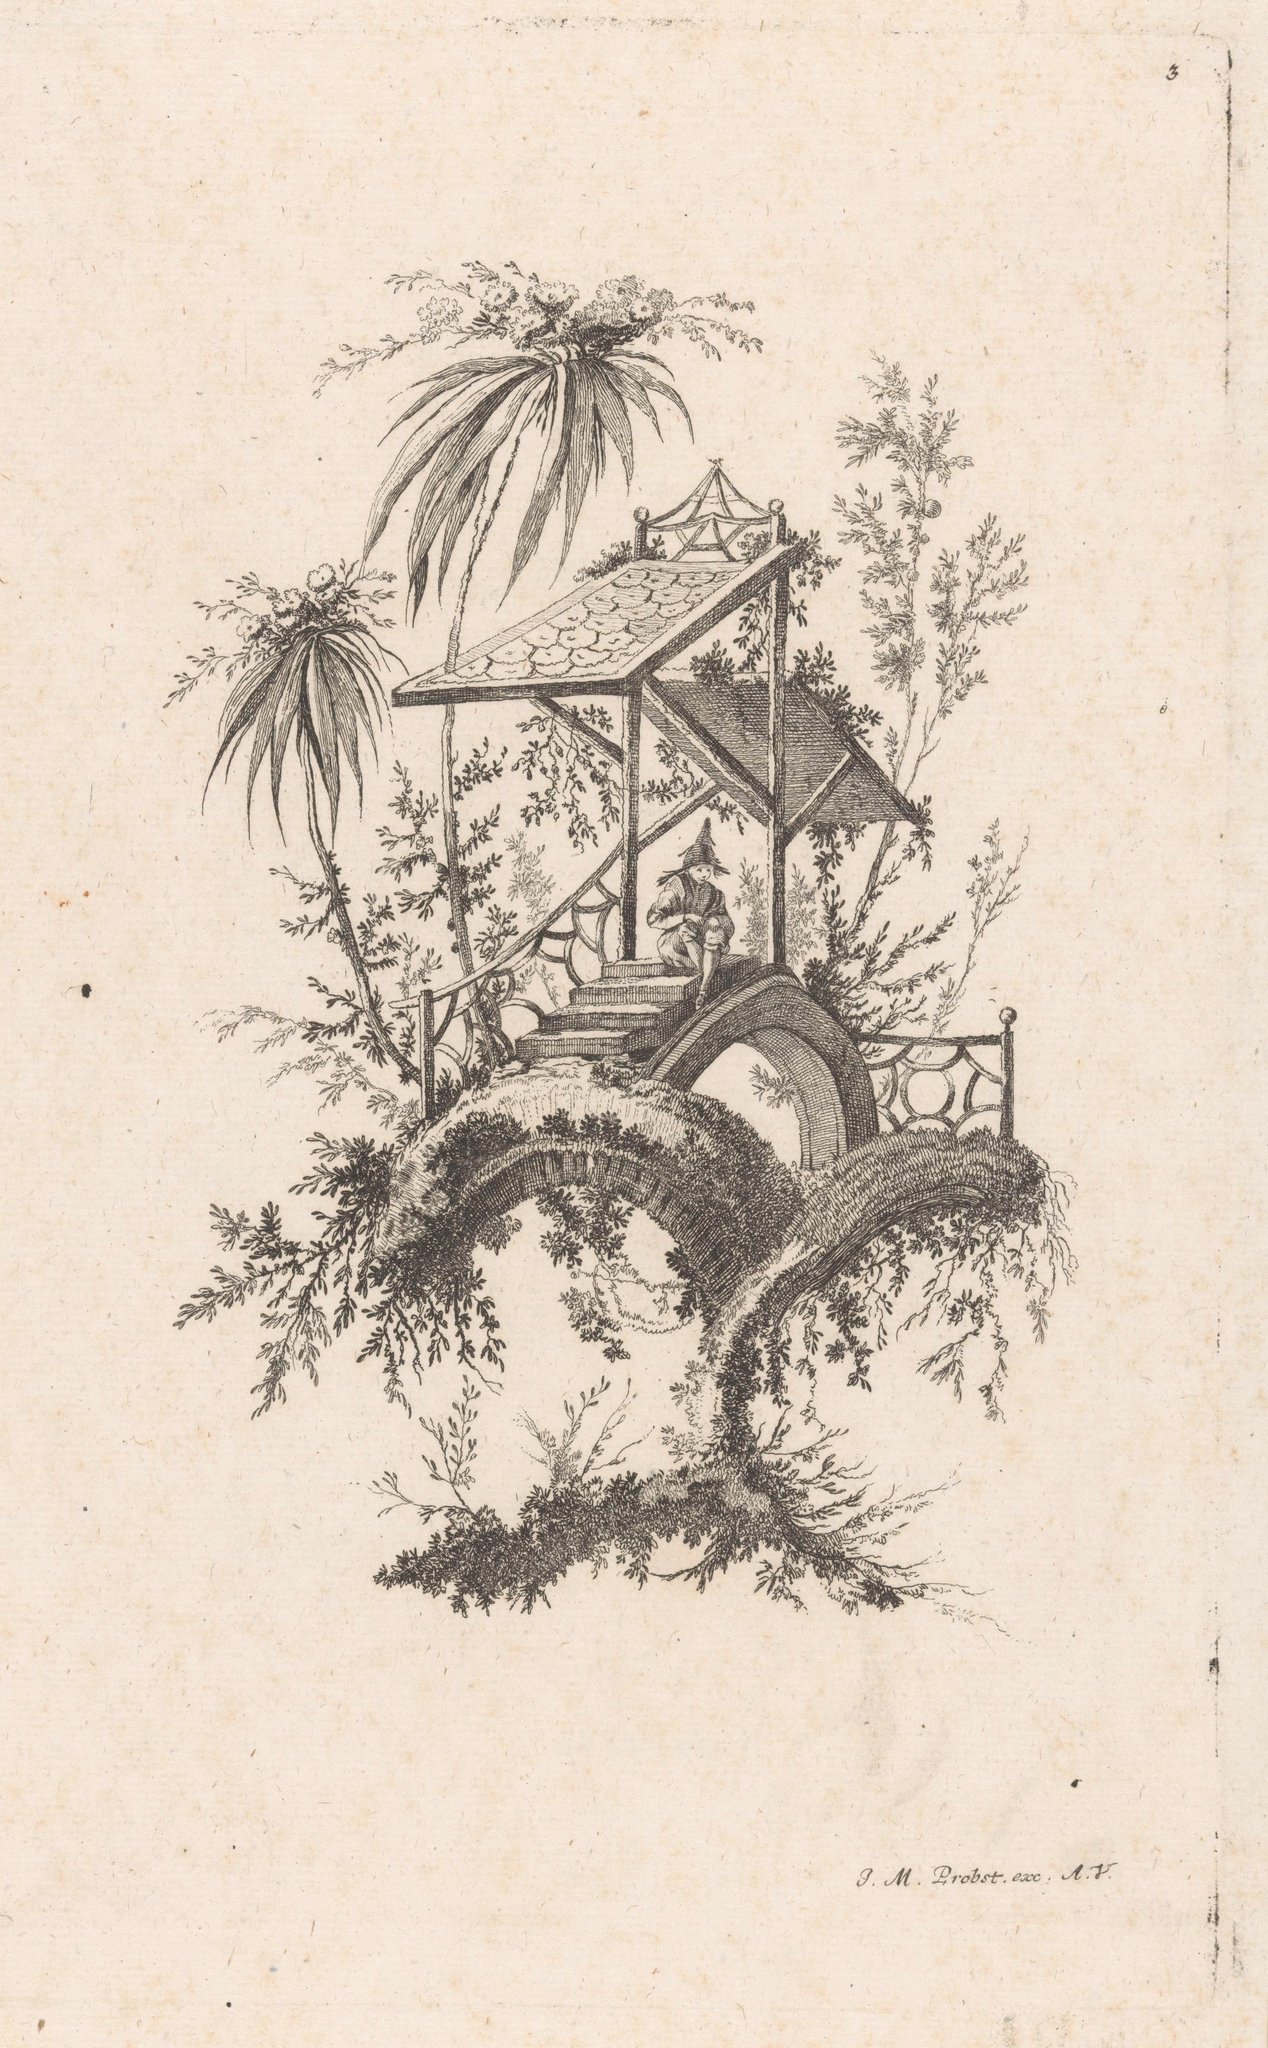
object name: print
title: Cahier de six Baraques Chinoises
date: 1776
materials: paper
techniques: etching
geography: augsburg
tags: sitting figure, staircase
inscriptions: collector's mark: Lugt 2228, collector's mark: Lugt 2760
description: In een landschap zit een man op een trap onder twee luifels.